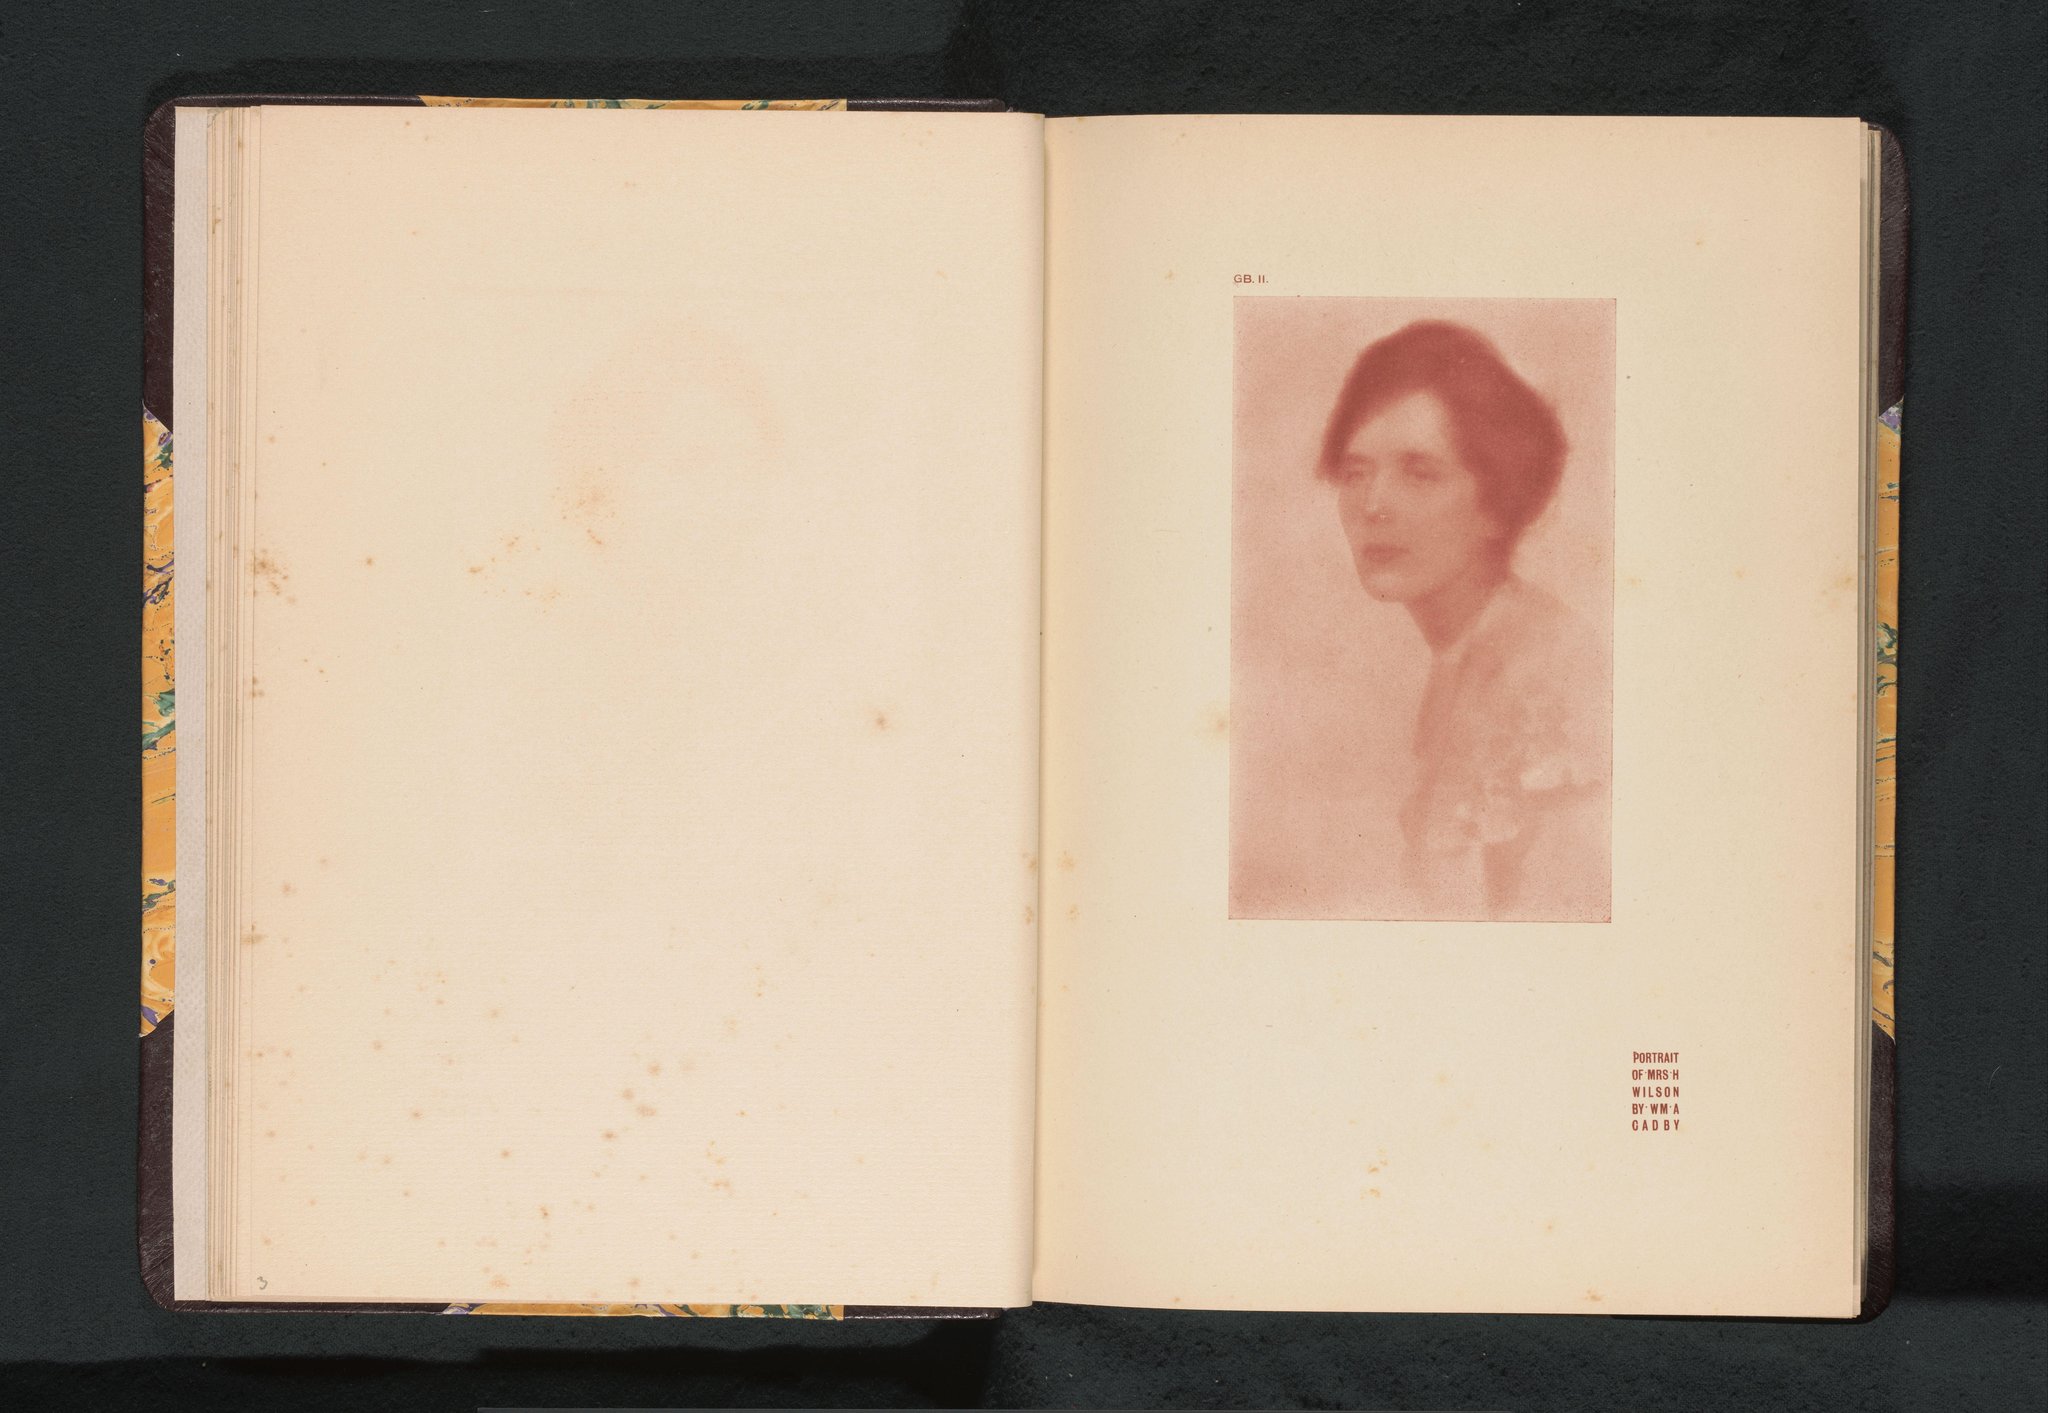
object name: page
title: Portret van een onbekende vrouw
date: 1900-1905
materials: paper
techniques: autotype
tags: historical persons - bb - woman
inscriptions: inscription: ‘Portrait of Mrs H Wilson by WM A Cadby’, inscription: ‘GB. II.’